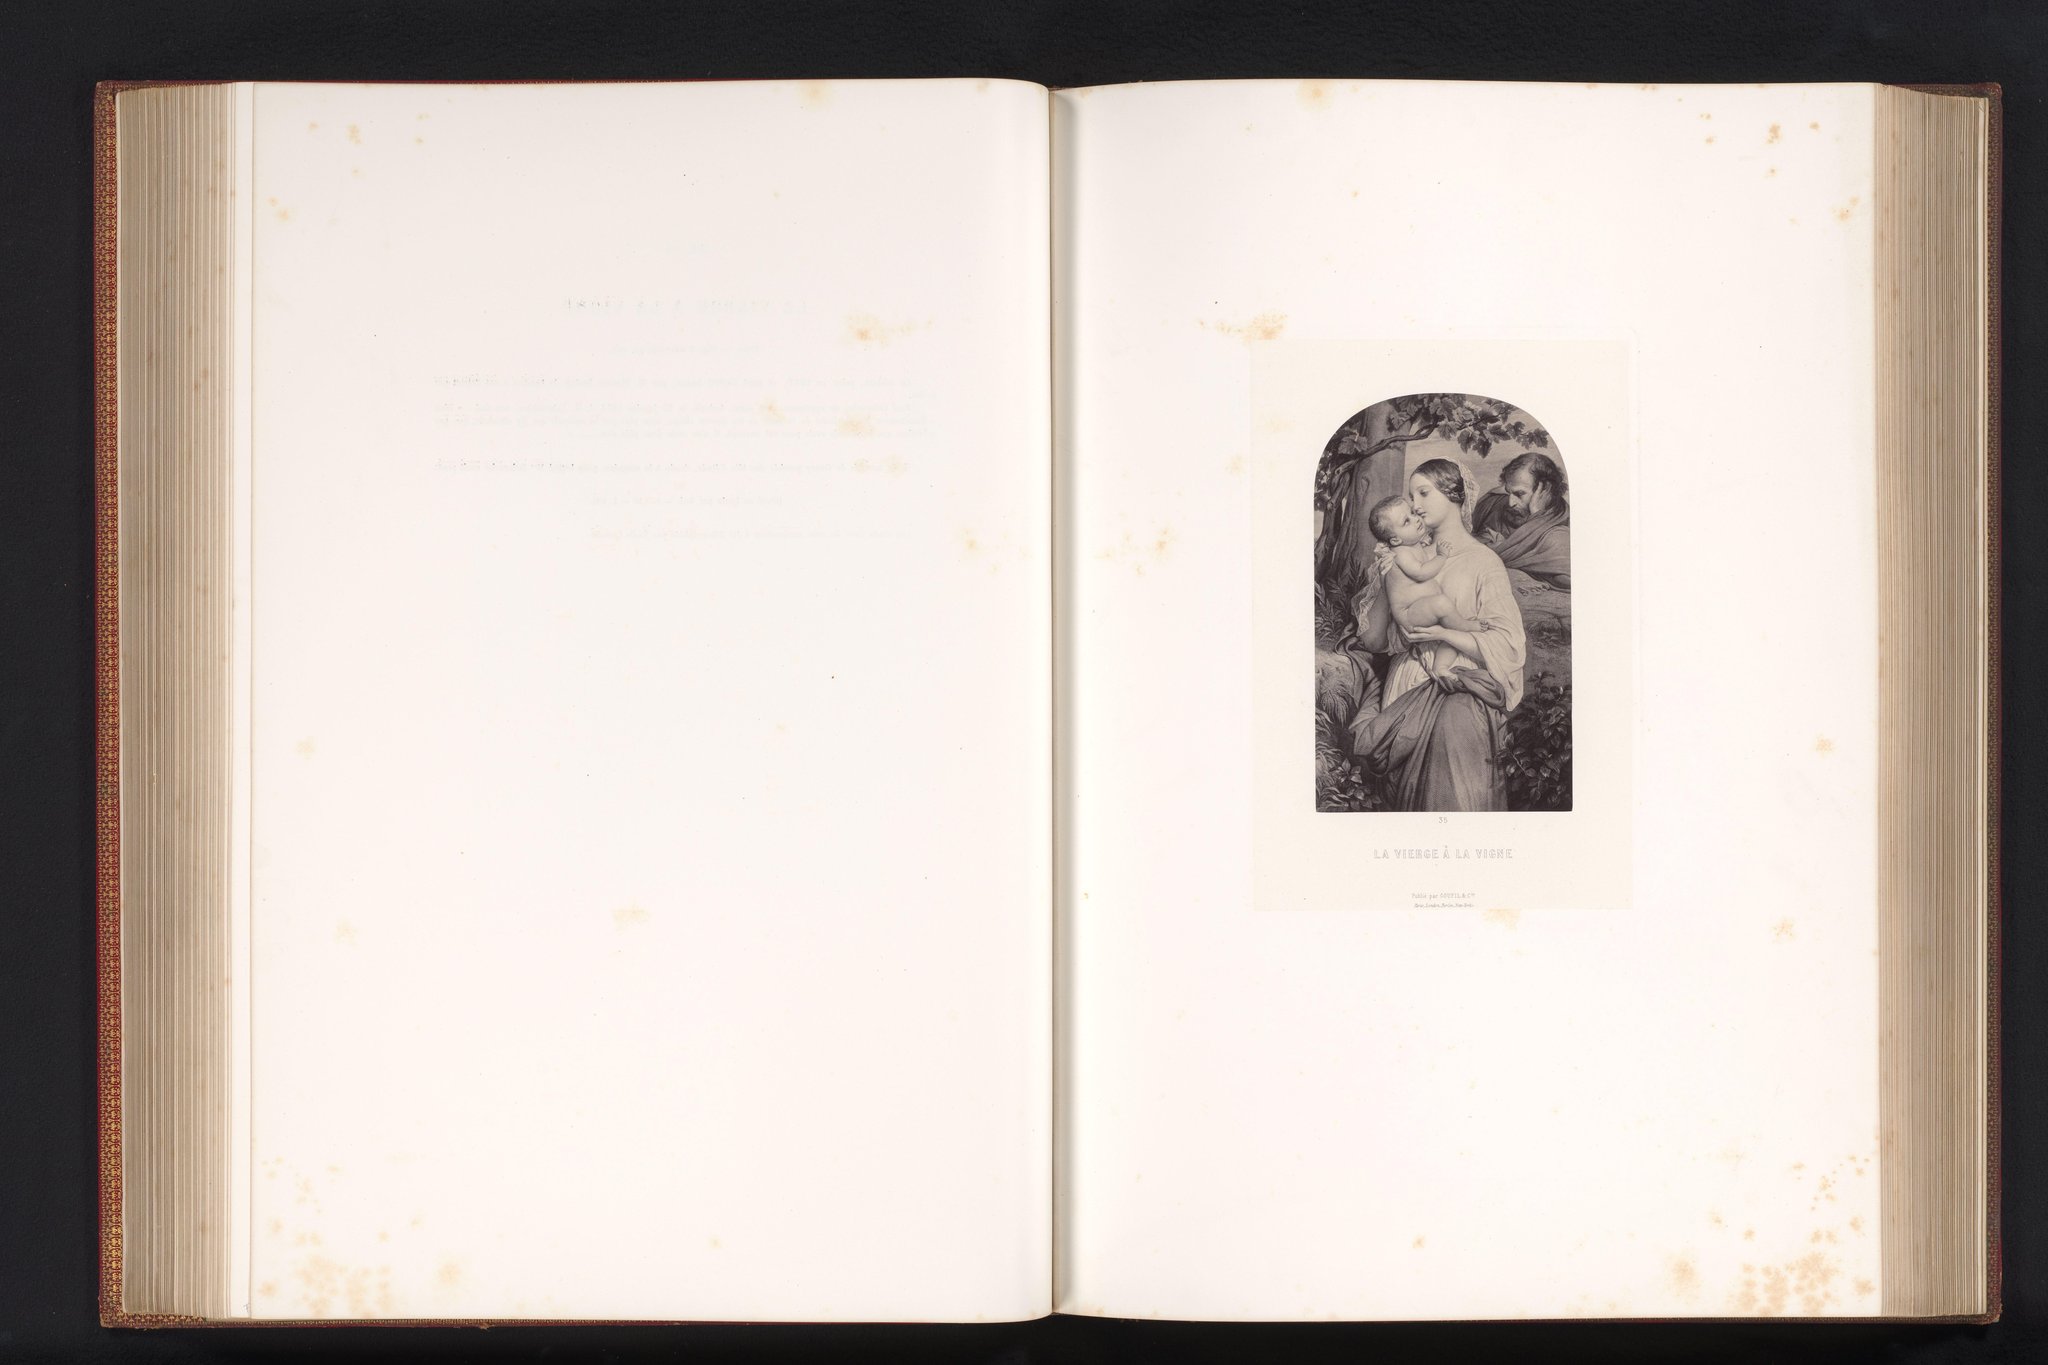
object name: page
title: Fotoreproductie van een prent naar een schilderij van Madonna met kind door Paul Delaroche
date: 1853-1858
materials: paper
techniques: albumen print, engraving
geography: paris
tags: mary standing (or half-length), the christ-child in front of her, close to her bosom; standing (+ donor(s), supplicant(s), whether or not with patron saint(s))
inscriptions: check stamp: ‘Goupil & Cie’